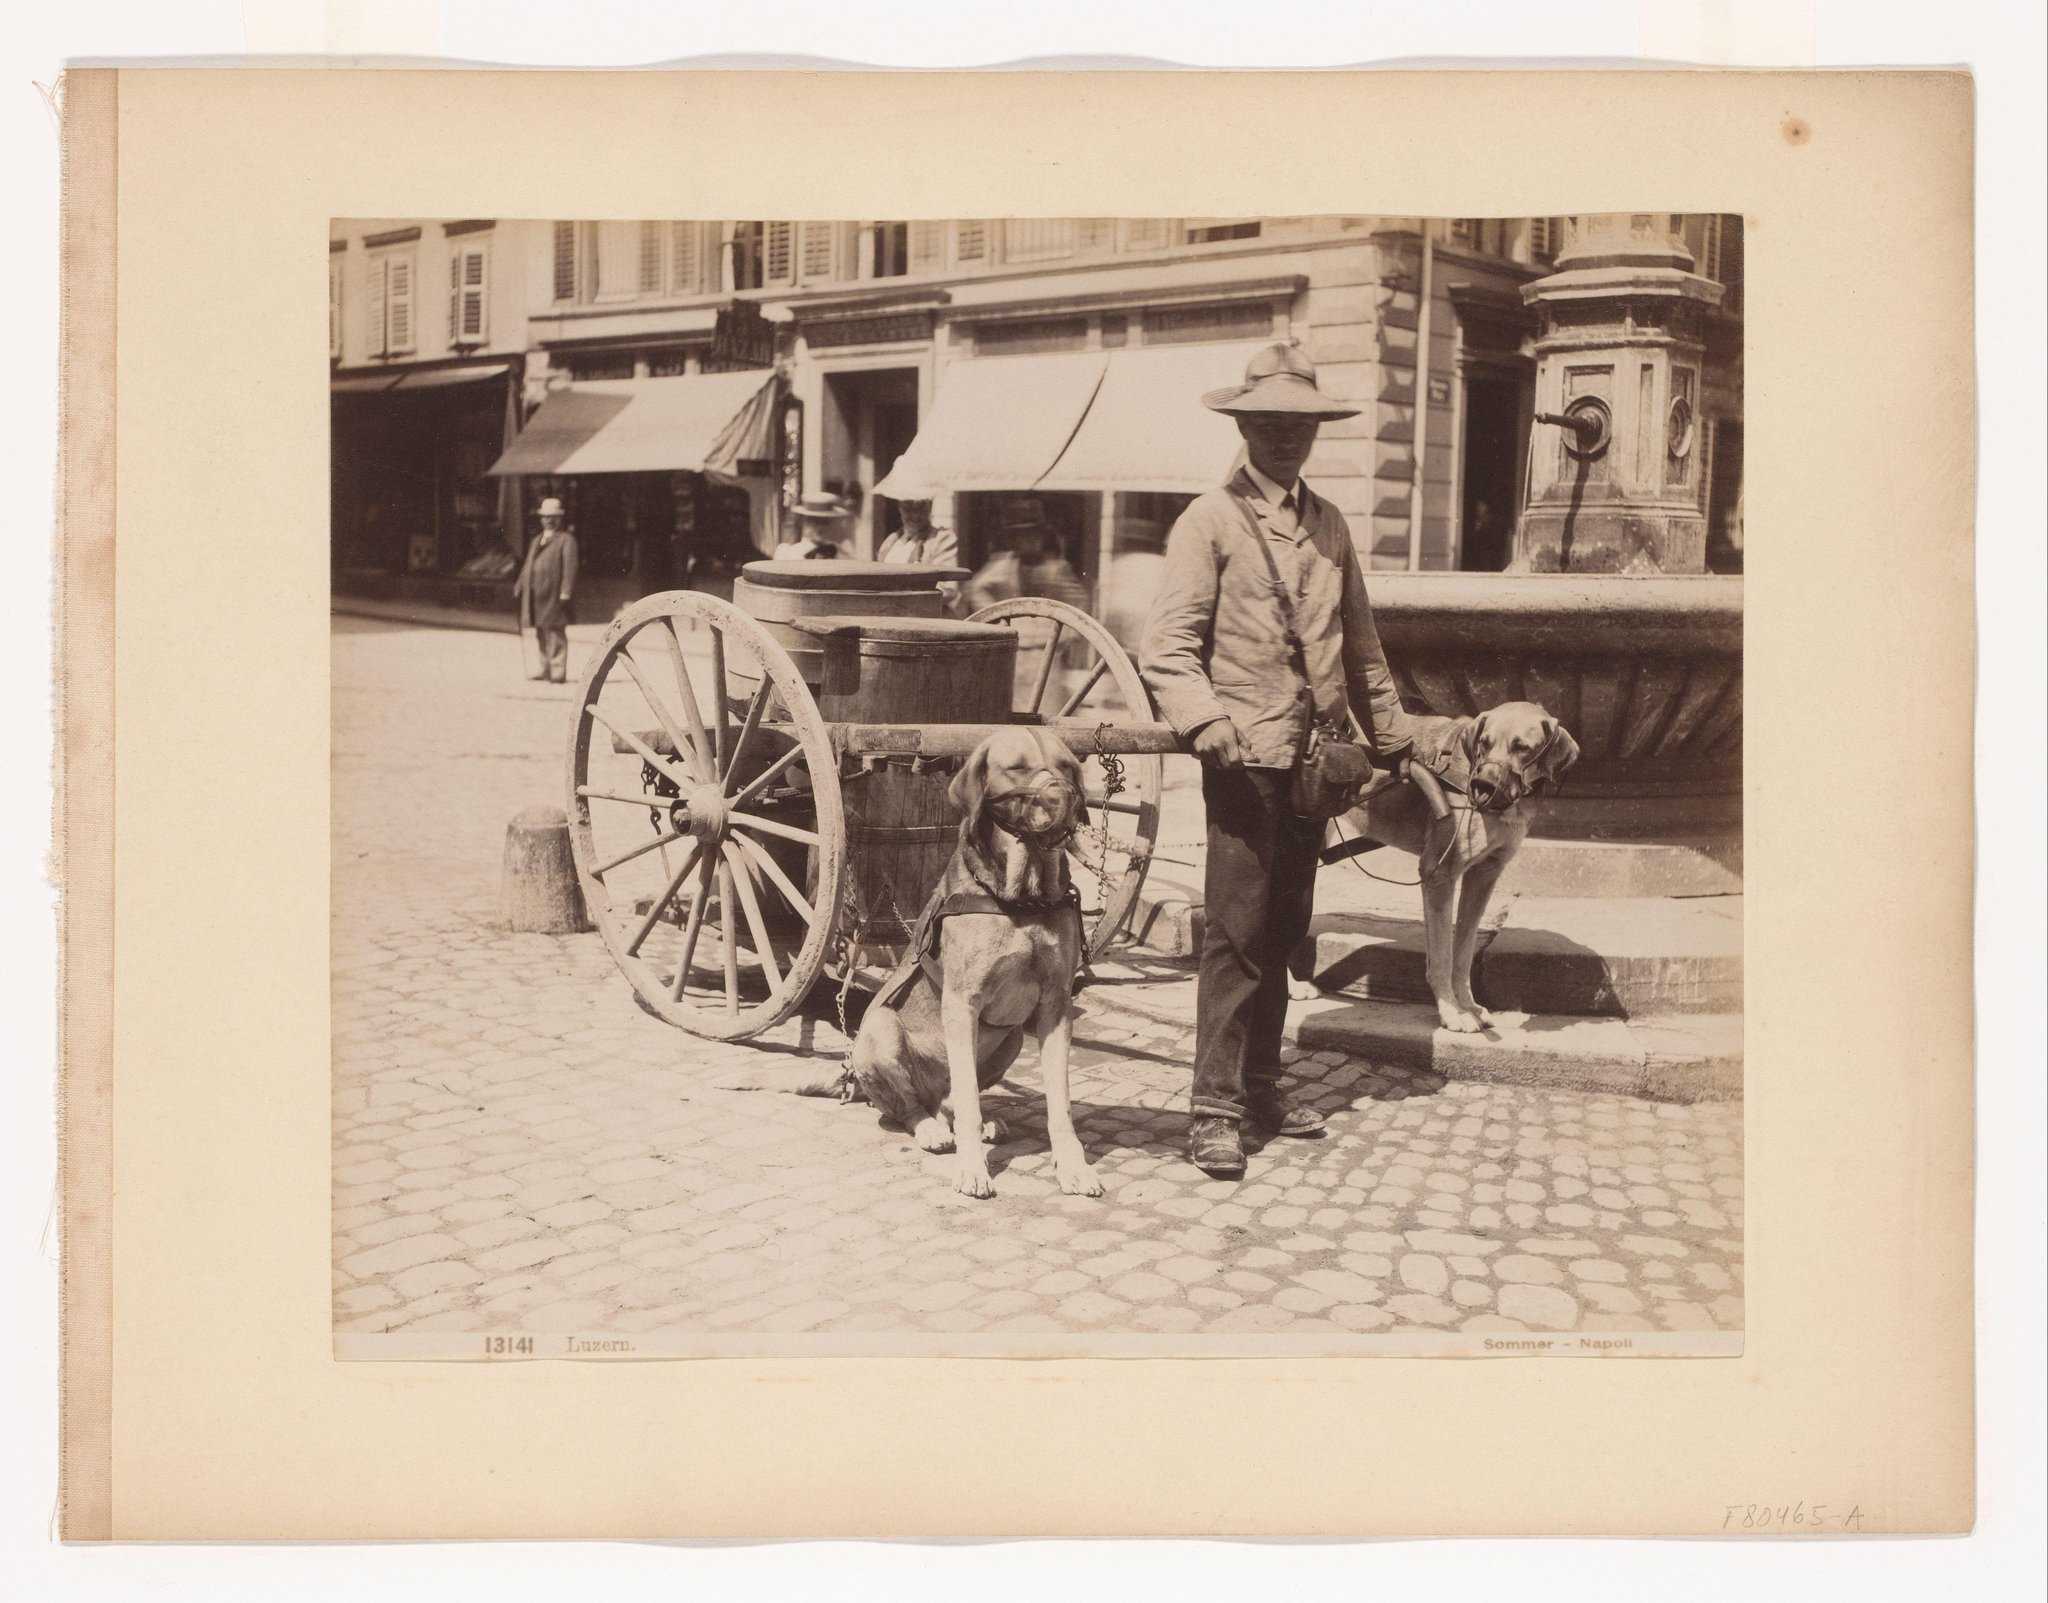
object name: photograph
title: Hondenkar op straat in Luzern, Zwitserland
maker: giorgio sommer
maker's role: fotograaf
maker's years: 1834-1914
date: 1857-1914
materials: cardboard, paper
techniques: albumen print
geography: lucerne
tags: two-wheeled, animal-drawn vehicle, street, dog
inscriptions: number: ‘13141’